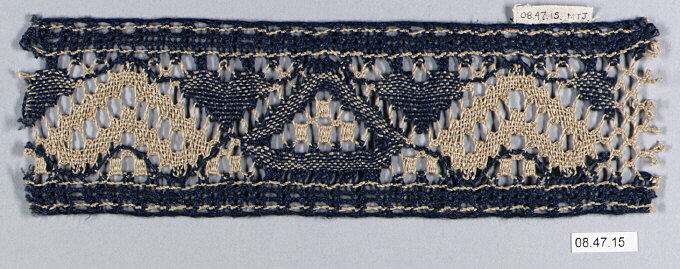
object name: fragment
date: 1801-1900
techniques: lace